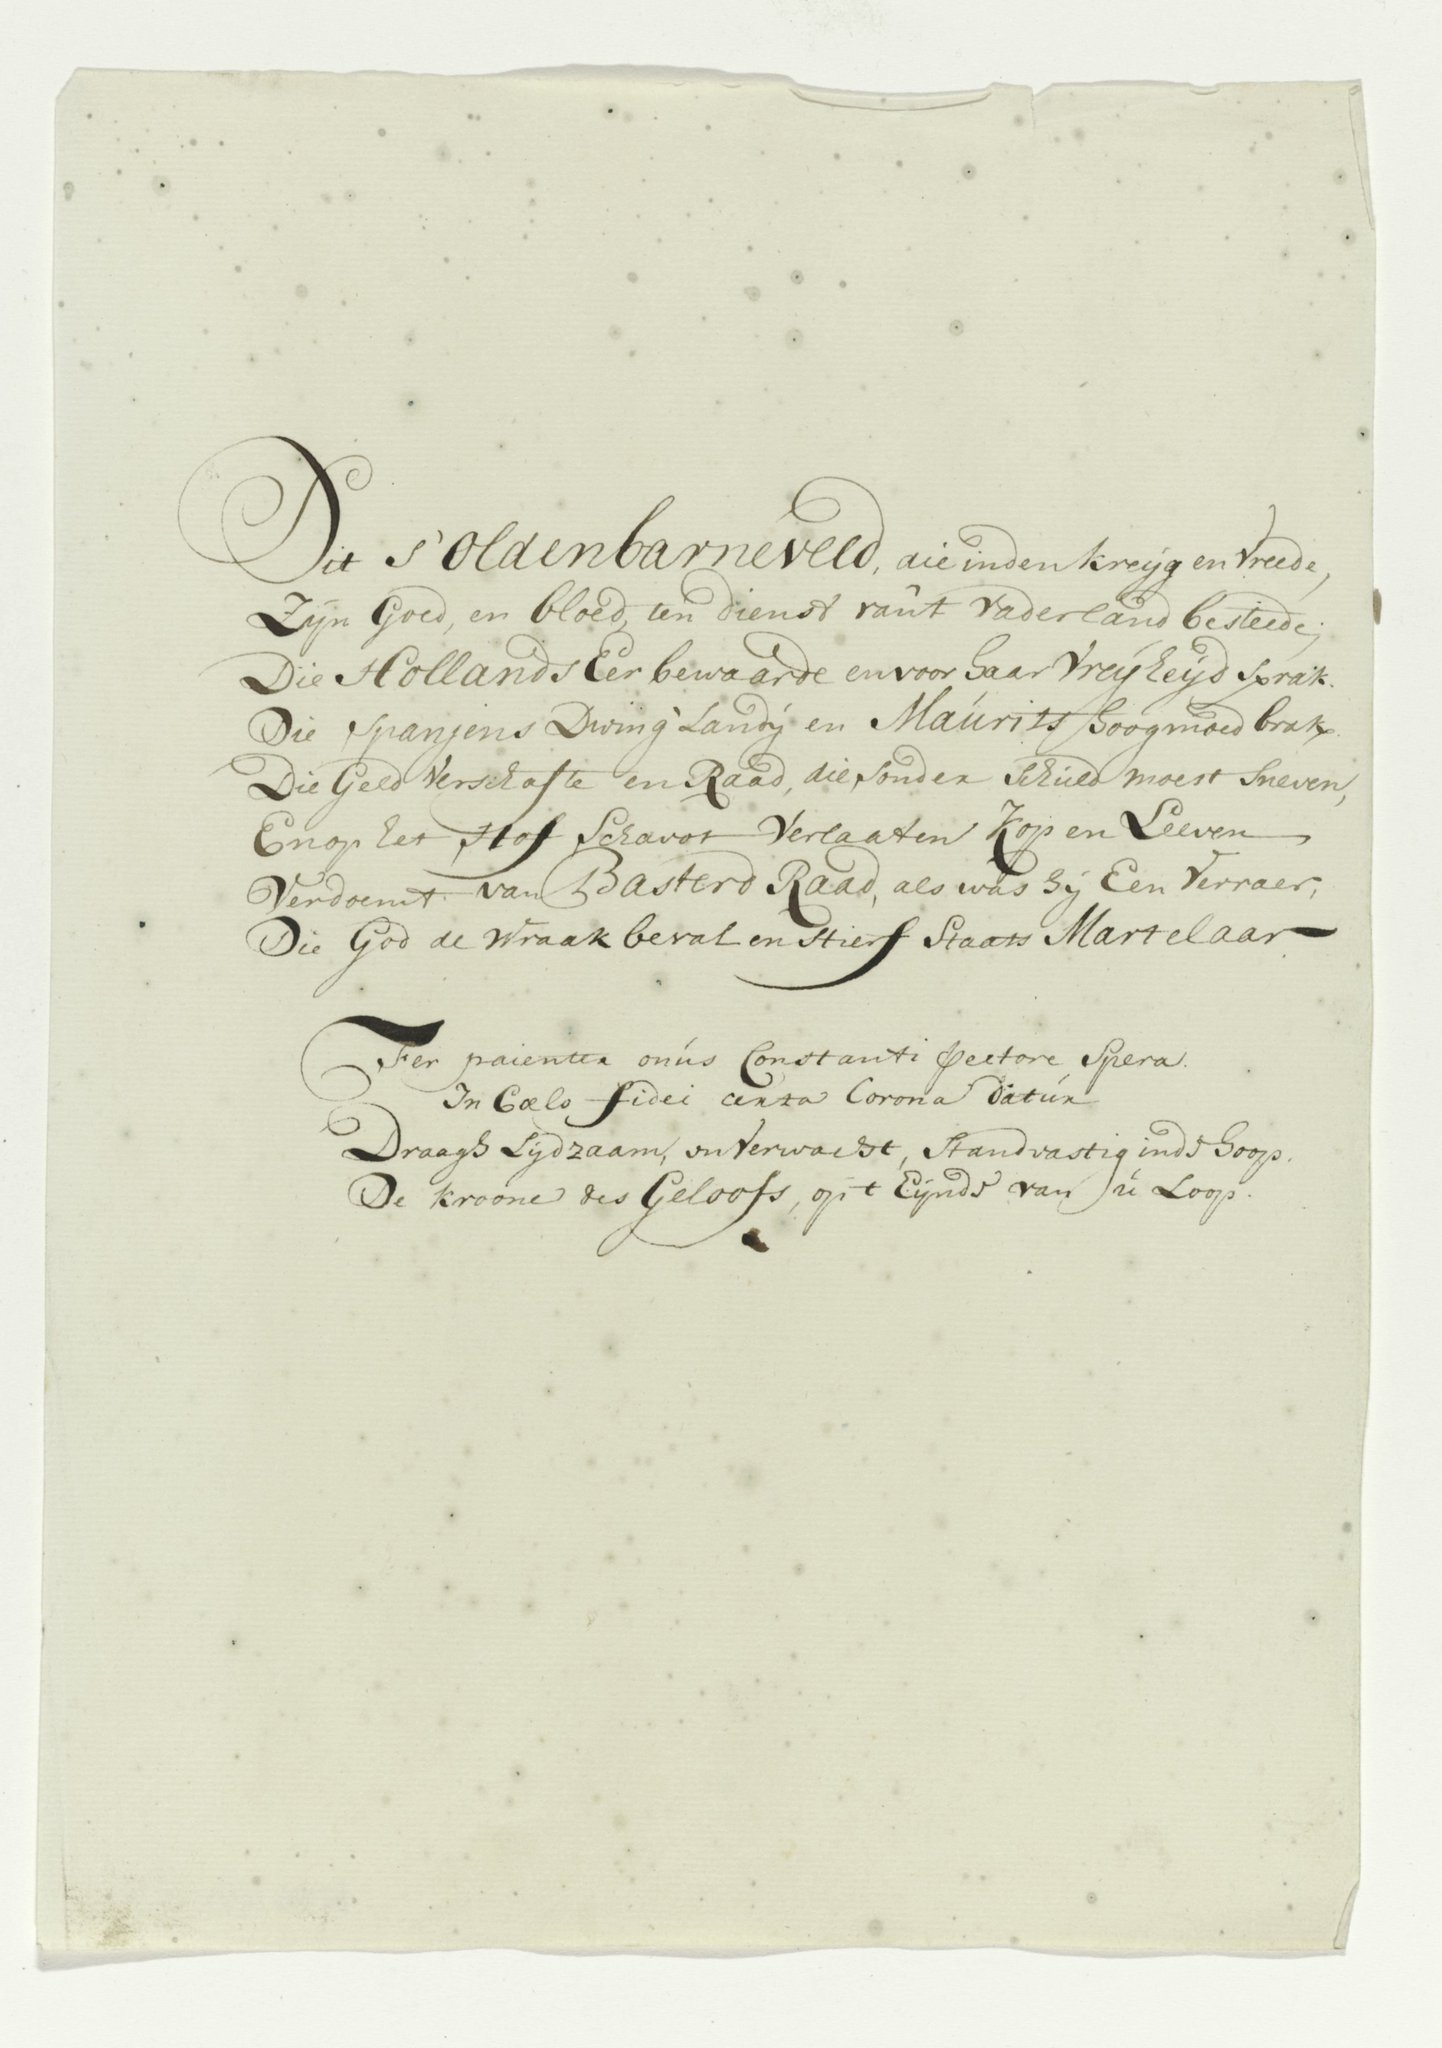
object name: manuscript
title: Spotvers bij het portret van Johan van Oldenbarnevelt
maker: Anonymous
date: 1710-1720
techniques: pen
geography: netherlands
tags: johan van oldenbarnevelt